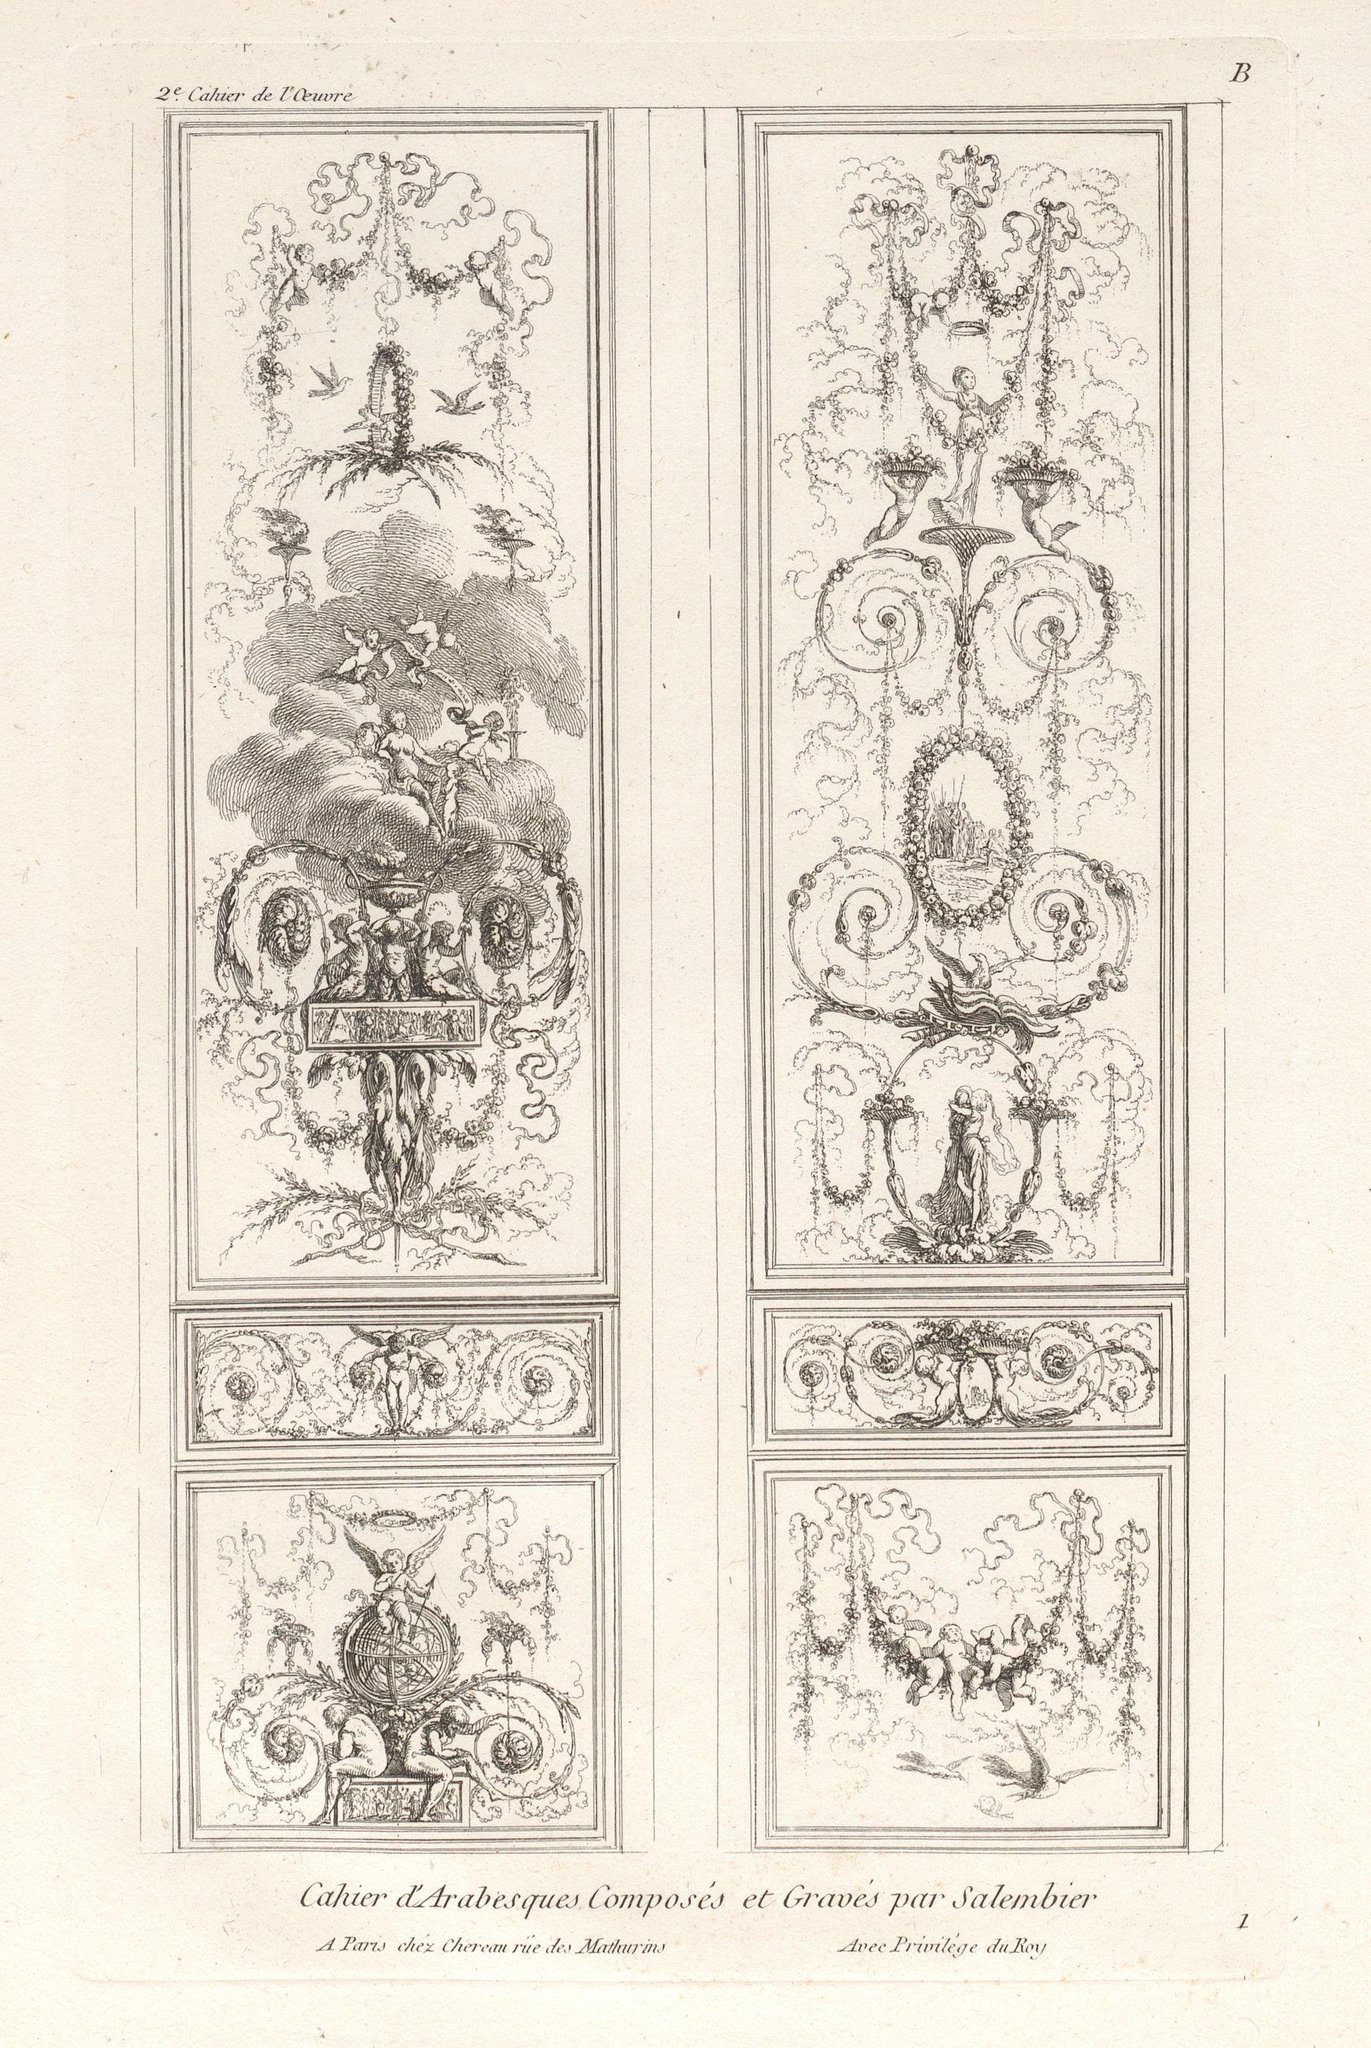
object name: titelprent, frontispice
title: Verzameling van arabesken, met de Vaticaanse loggia's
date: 1802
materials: paper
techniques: etching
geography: paris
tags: cupid handling his weapons, ornament ~ arabesque, (lovers) embracing each other, 'symplegma', cupids: 'amores', 'amoretti', 'putti', ornament derived from plant forms, doves, pigeons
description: Doordat dit album bestaat uit meerdere, deels eerder uitgegeven prentreeksen, is de datering niet consequent. Het geheel is op de titelpagina gedateerd op 1802. Deze reeks is niet afzonderlijk gedateerd. De serietitel voor het gehele werk is "Recueil d'arabesques, contenant les loges du Vatican". De andere serietitel is de titel van de specifieke reeks binnen het geheel.